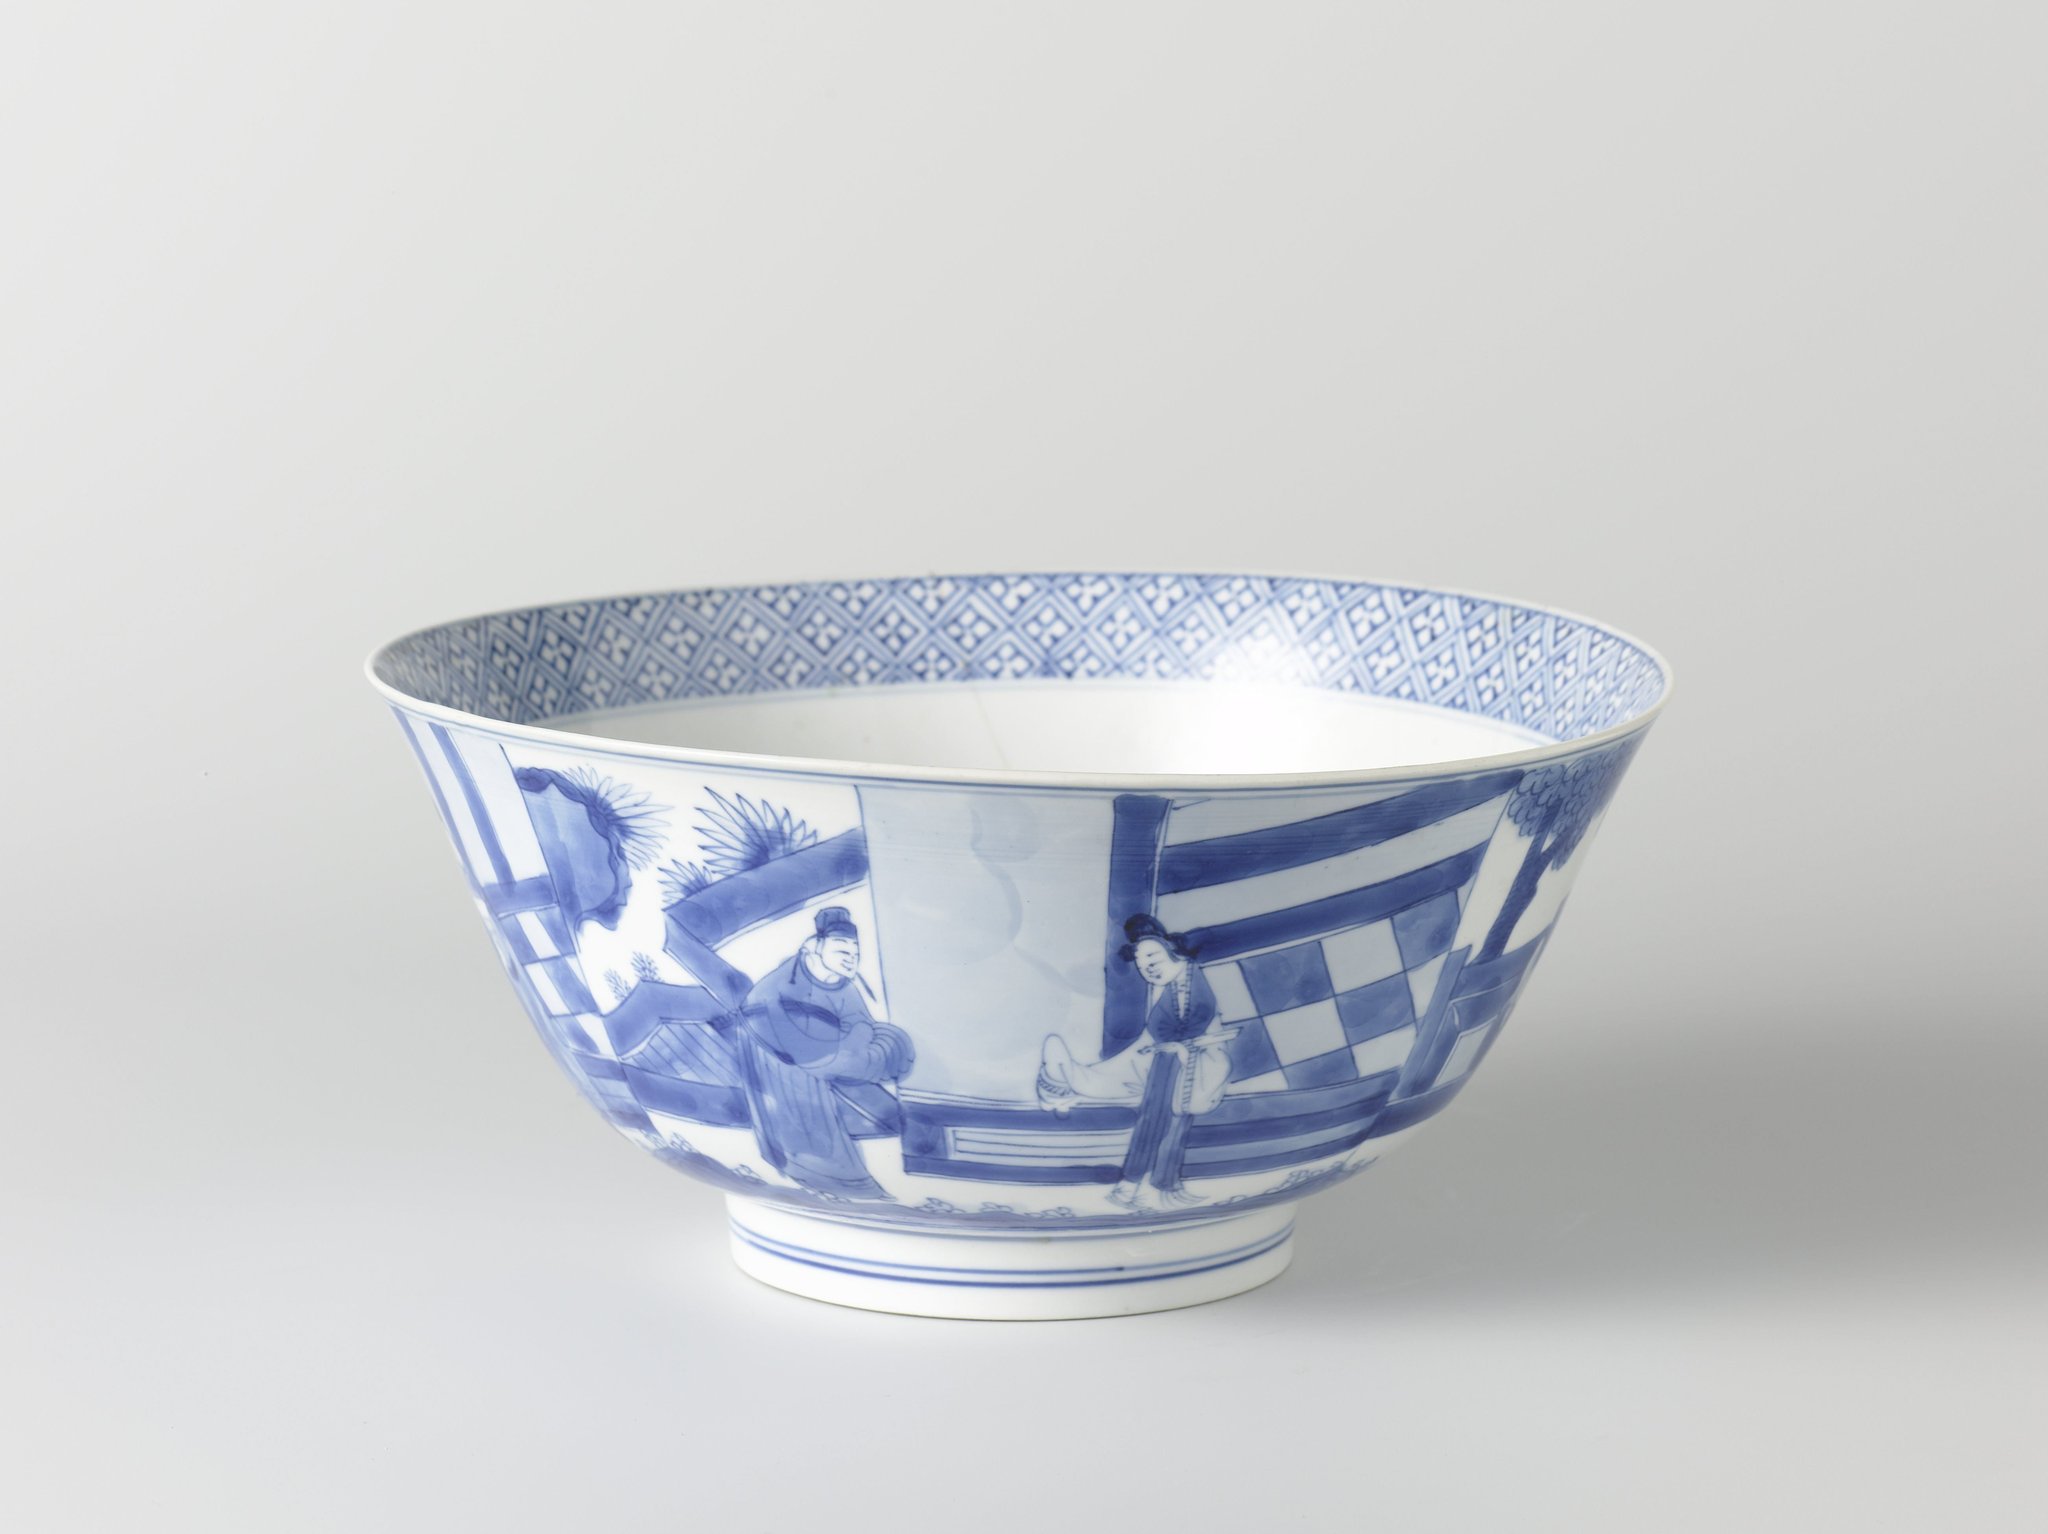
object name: bowl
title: Bell-shaped bowl with four narrative scenes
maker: Anonymous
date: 1680-1720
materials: cobalt, glaze, paint, porcelain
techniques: firing, turning, vitrification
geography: china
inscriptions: mark: ‘大 清 康 熙 年 製’